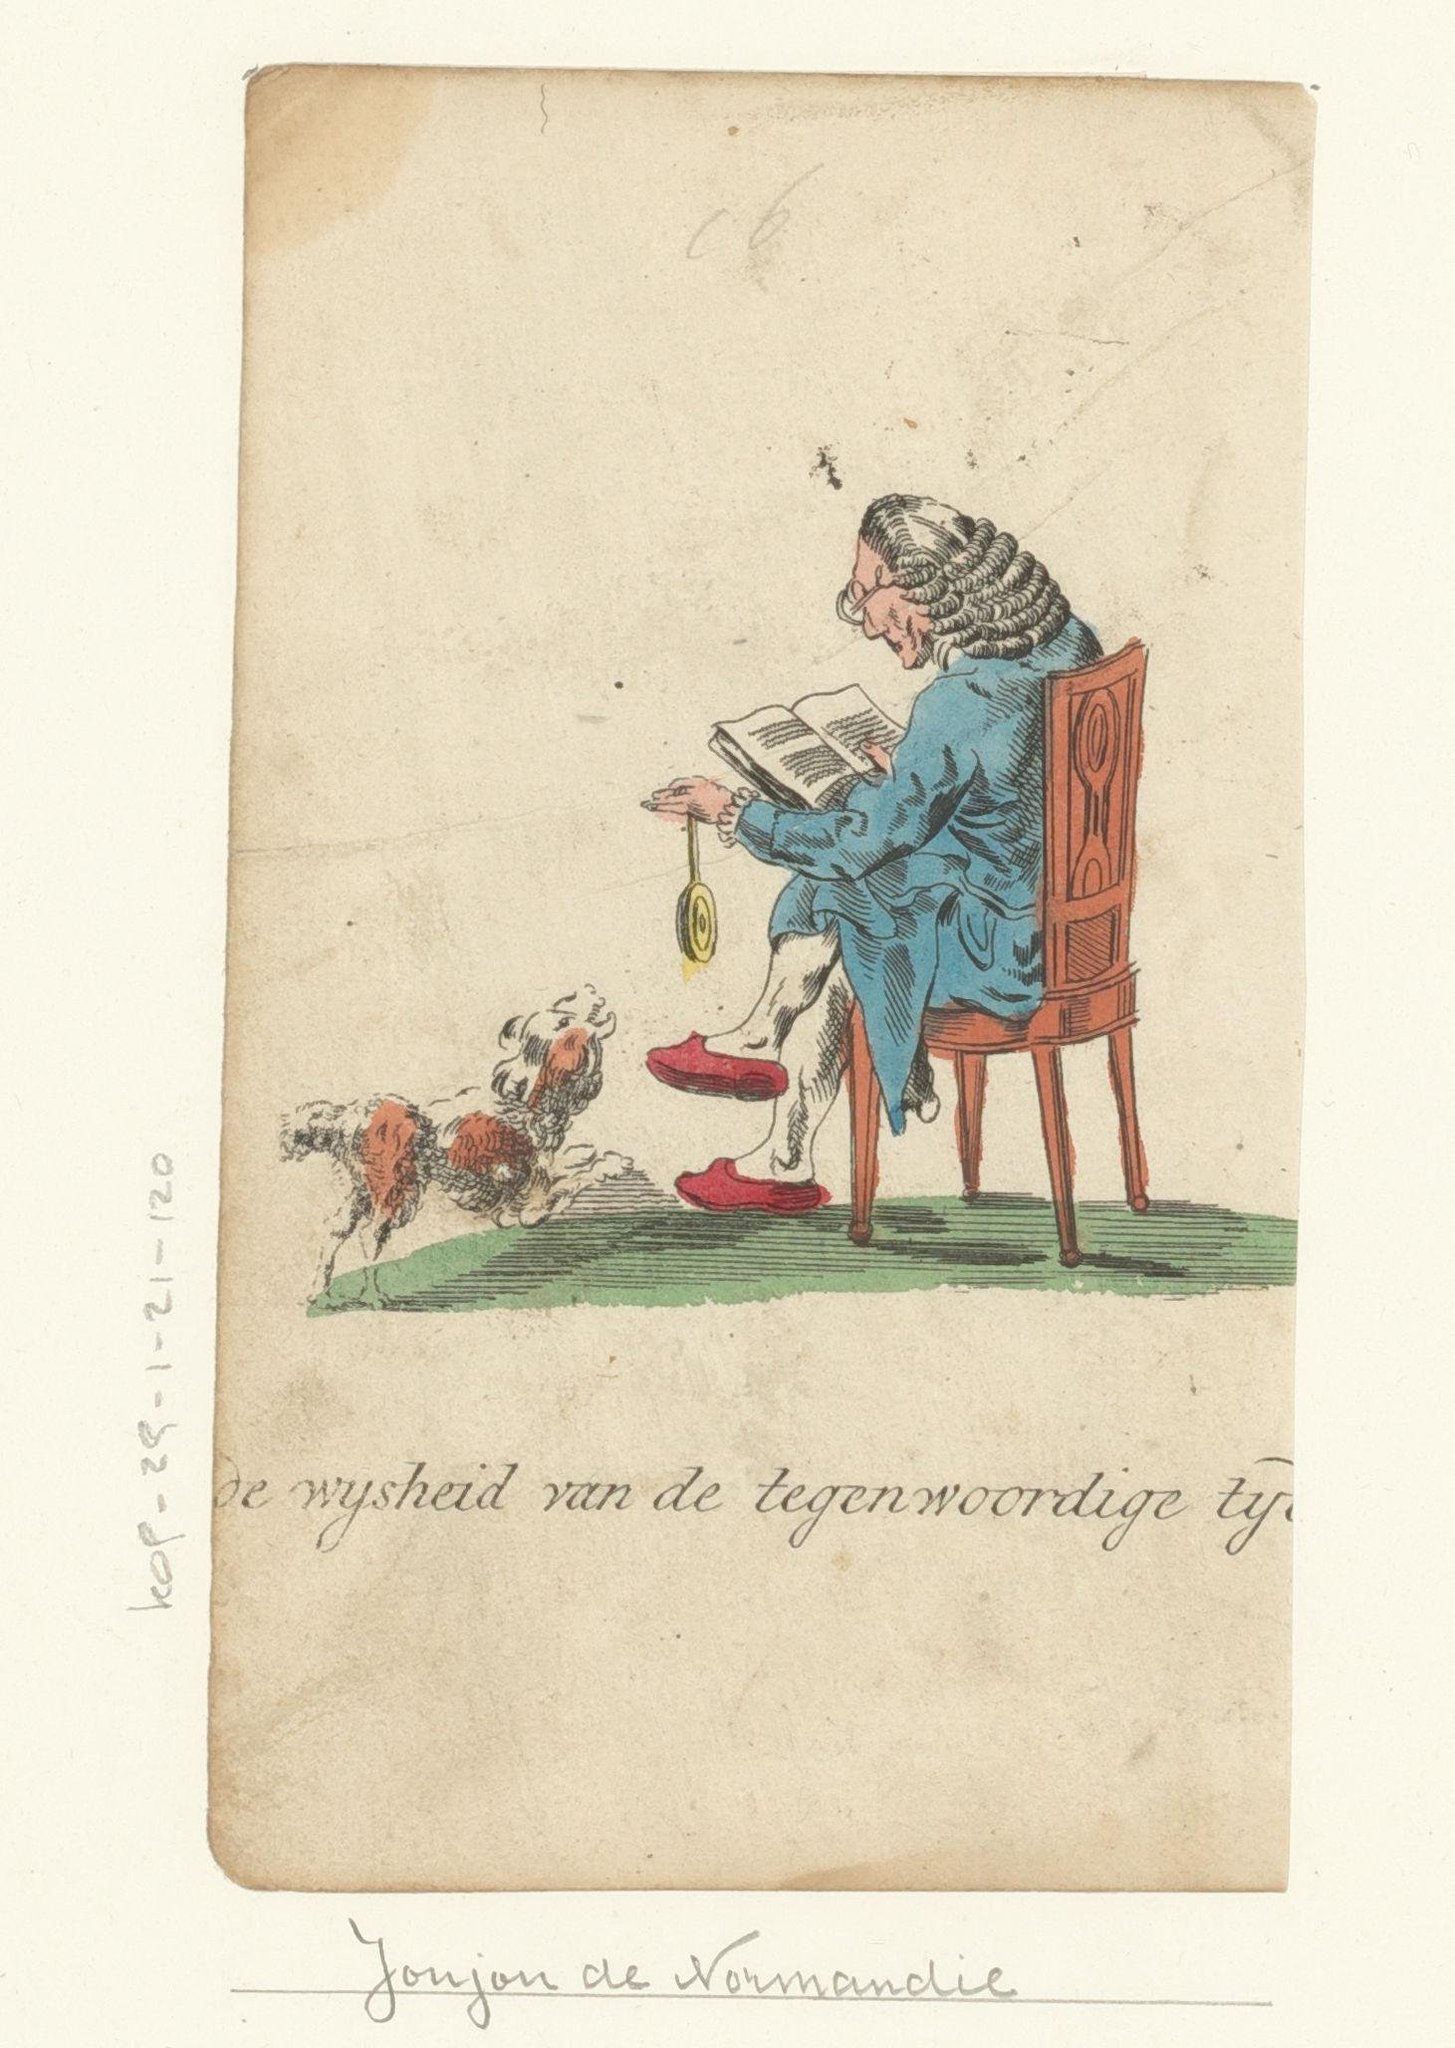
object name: print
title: Man op een stoel speelt met een jojo terwijl hij leest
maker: Anonymous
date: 1821-1829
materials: paper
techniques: engraving, etching, hand coloring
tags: reading, chair, yoyo, dog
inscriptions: collector's mark: Lugt 1641, stamp, collector's mark: Lugt 1641a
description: Prent waarschijnlijk uit: Hans Beuling, of St. Nicolaas- Nieuwejaars- Vastenavond- en kermisvermaak. Voor kinderen. Rotterdam: B. Schuurling, s.a [1821-1829]. Volgens de Atlas van Stolk ook gebruikt in: De nieuwe toverlantaarn. Amsterdam: s.n., 1797.